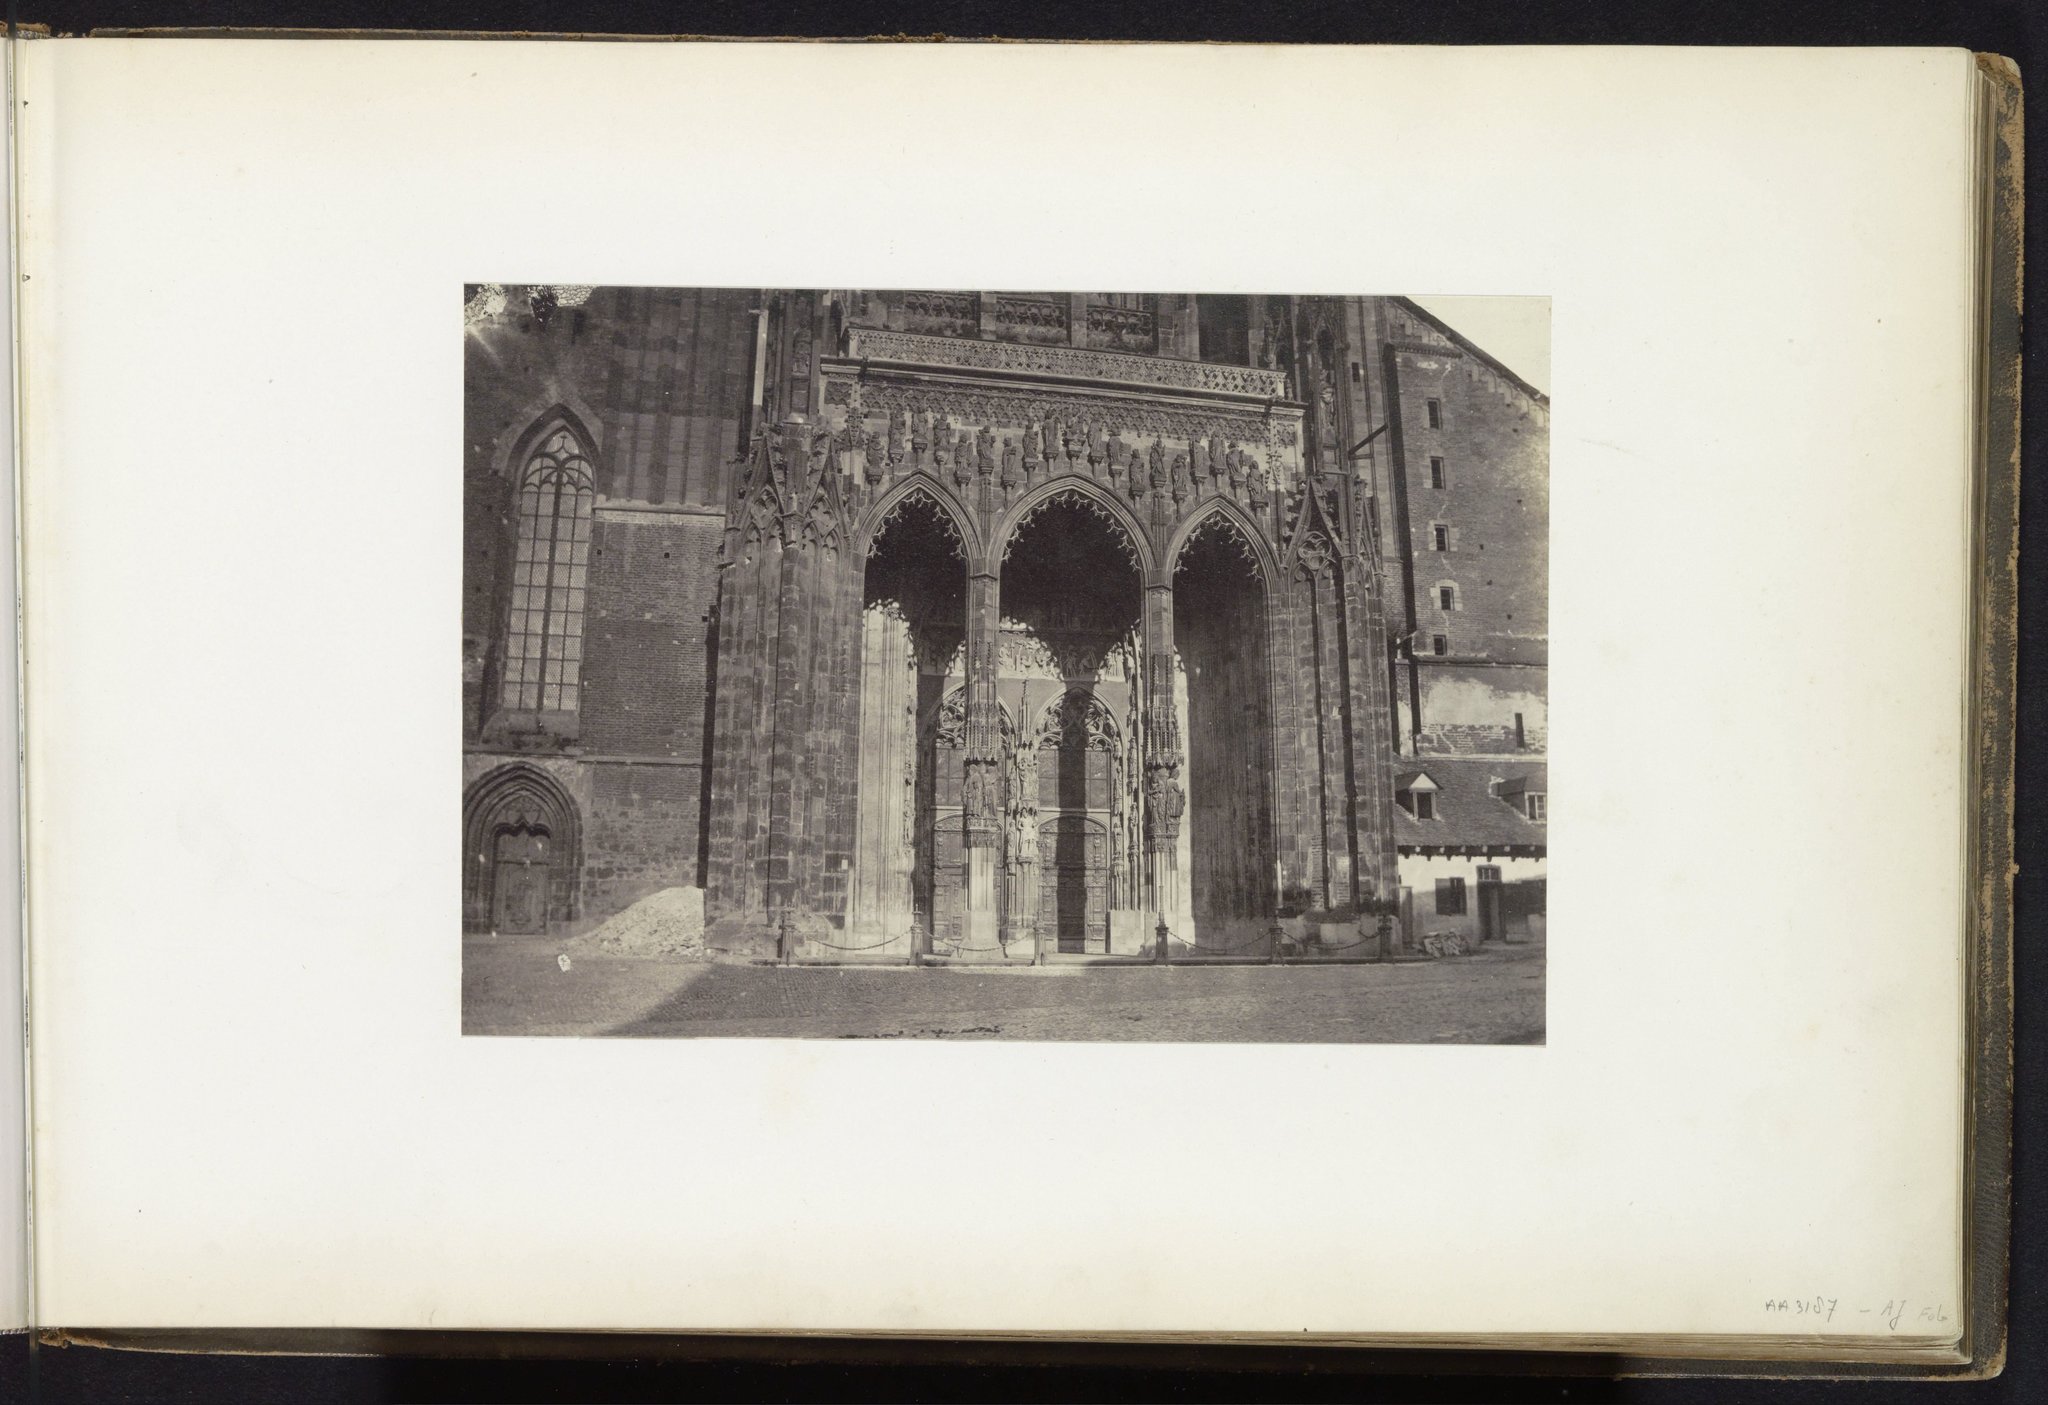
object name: album leaf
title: Kerkportaal, vermoedelijk in Midden-Europa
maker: Anonymous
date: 1865-1875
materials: photographic support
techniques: albumen print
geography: central europe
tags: parts of church exterior and annexes: portal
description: Onderdeel van Reisalbum met opnames van bezienswaardigheden in India, Duitsland, Zwitserland en Frankrijk.